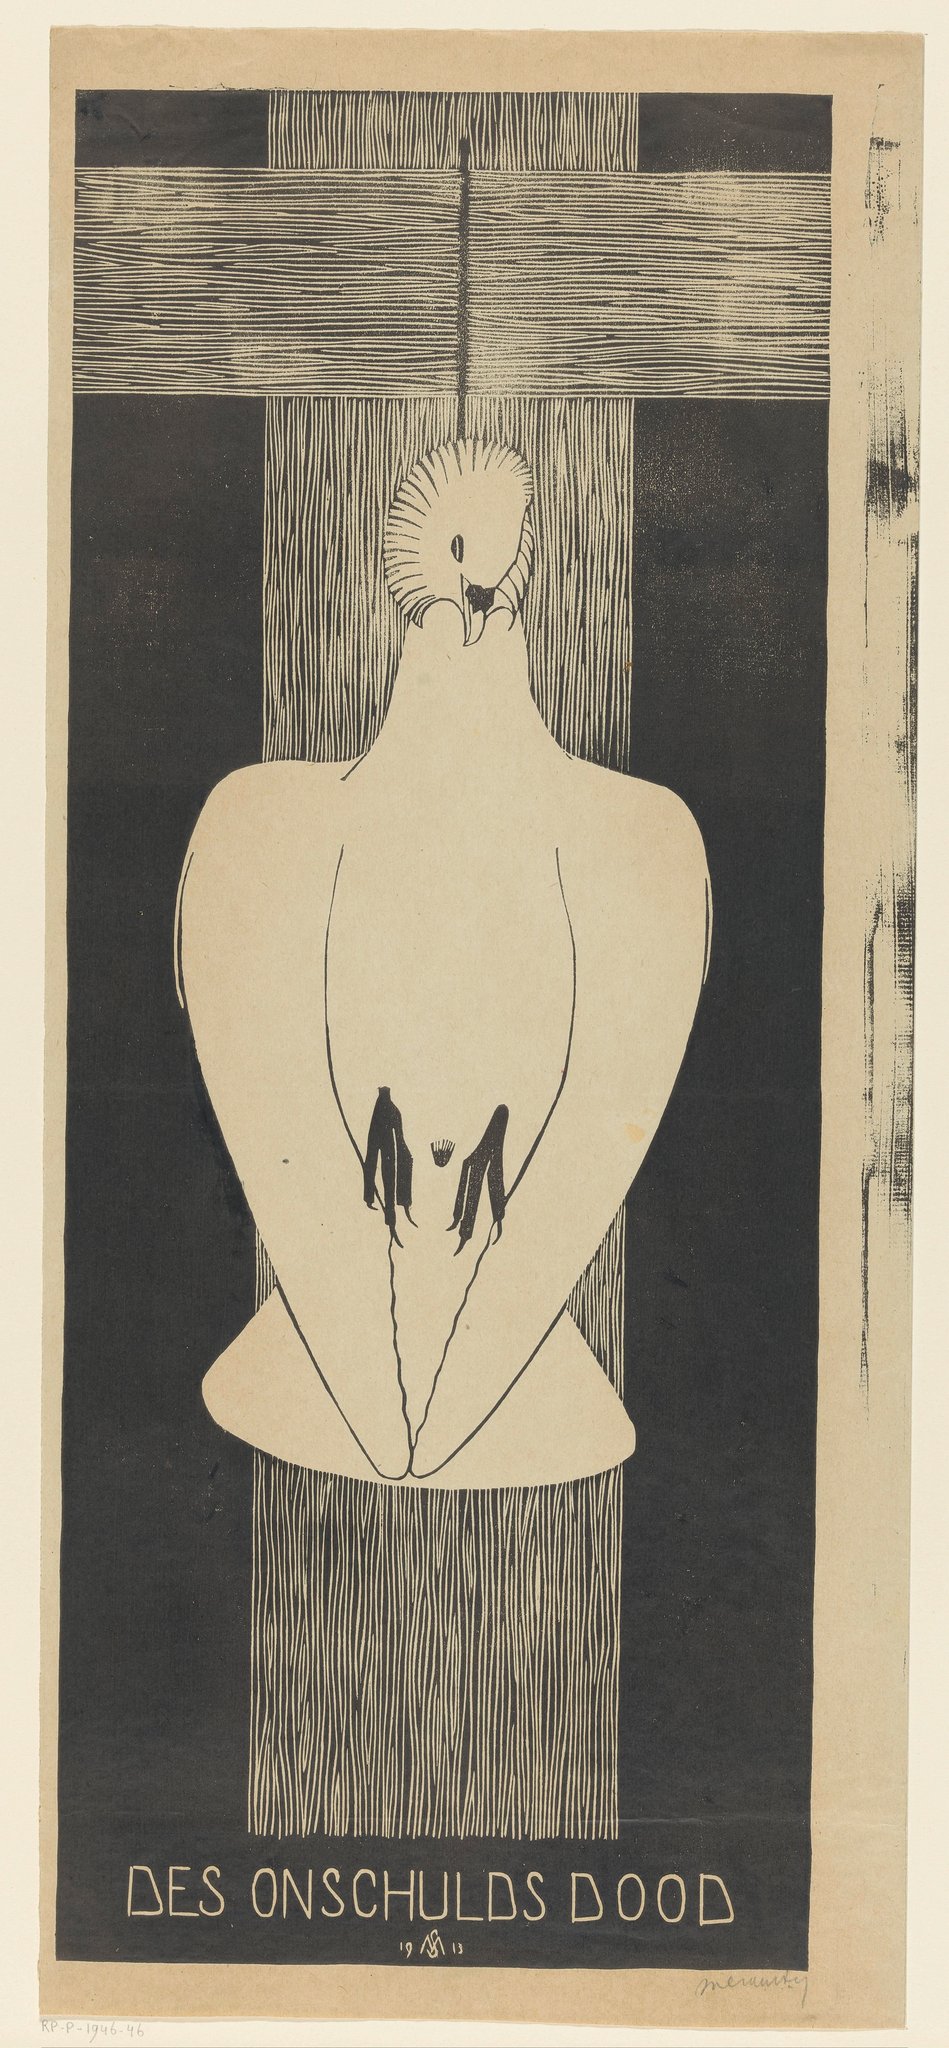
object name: print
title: Des onschulds dood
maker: samuel jessurun de mesquita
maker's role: draughtsman, print maker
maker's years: 1868-1944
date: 1913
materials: paper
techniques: woodcut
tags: doves, pigeons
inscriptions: collector's mark: Lugt 2228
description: Een dode duif hangt aan een houten kruis.